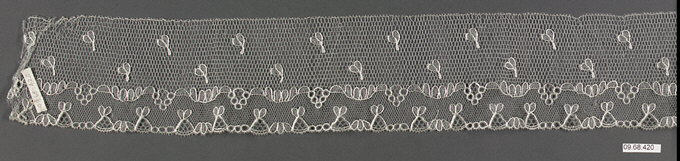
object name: bobbin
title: Silk bobbin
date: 1801-1900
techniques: lace